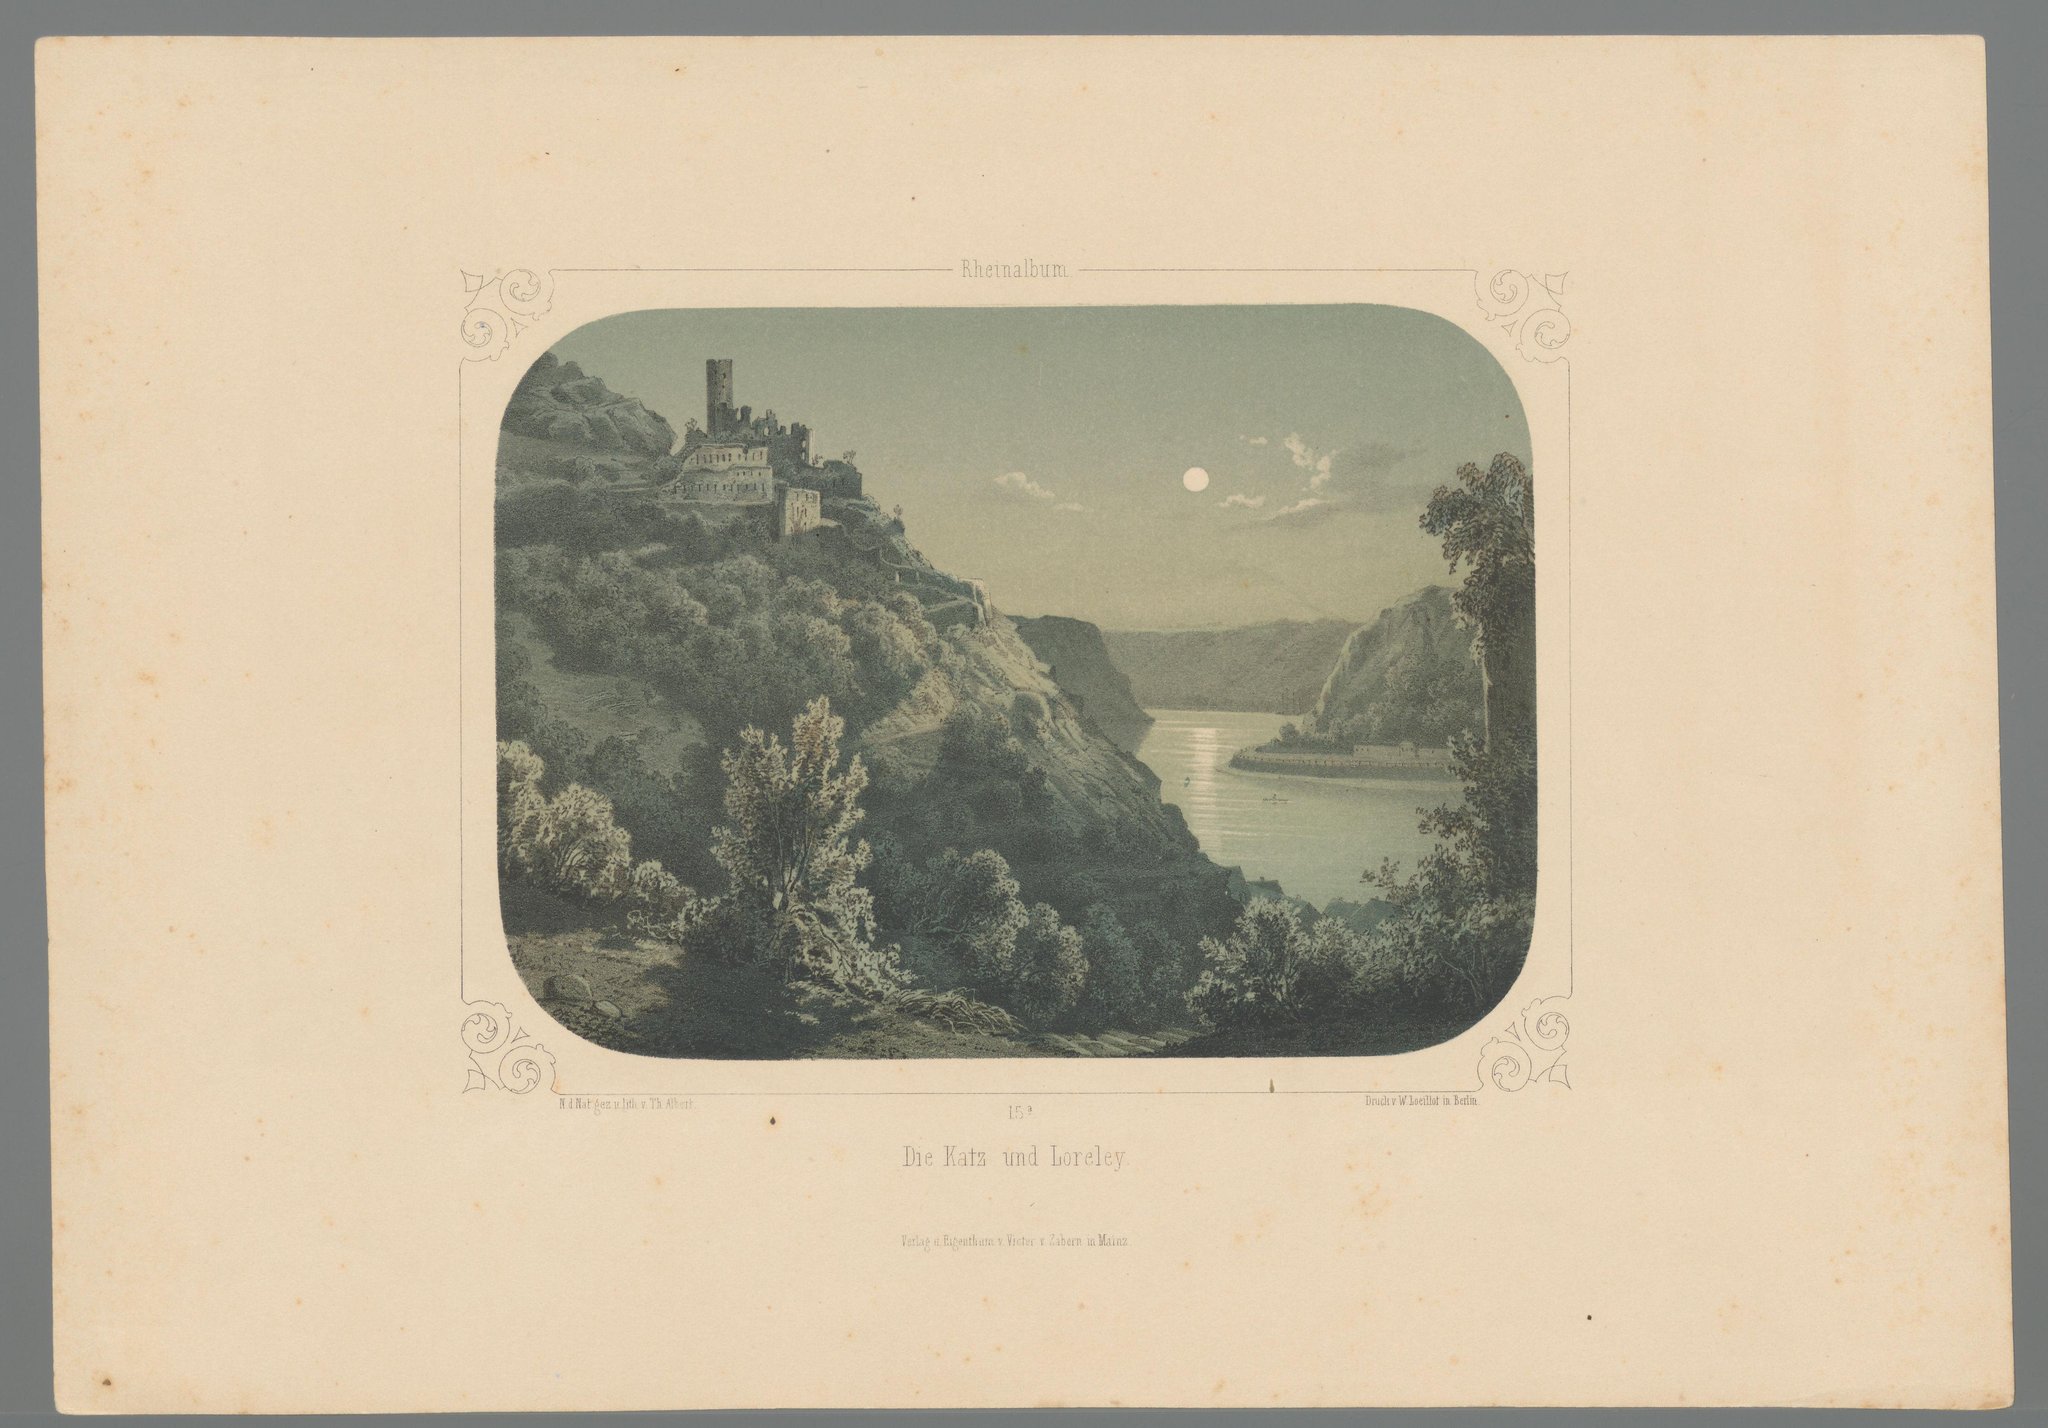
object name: print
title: Die Katz und Loreley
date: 1858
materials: paper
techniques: tone lithography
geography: berlin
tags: river, landscape with tower or castle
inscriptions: collector's mark: Lugt 2228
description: Prent maakt deel uit van een serie van 36 prenten, waarbij het eveneens mogelijk was deze te laten samenbinden tot een album.